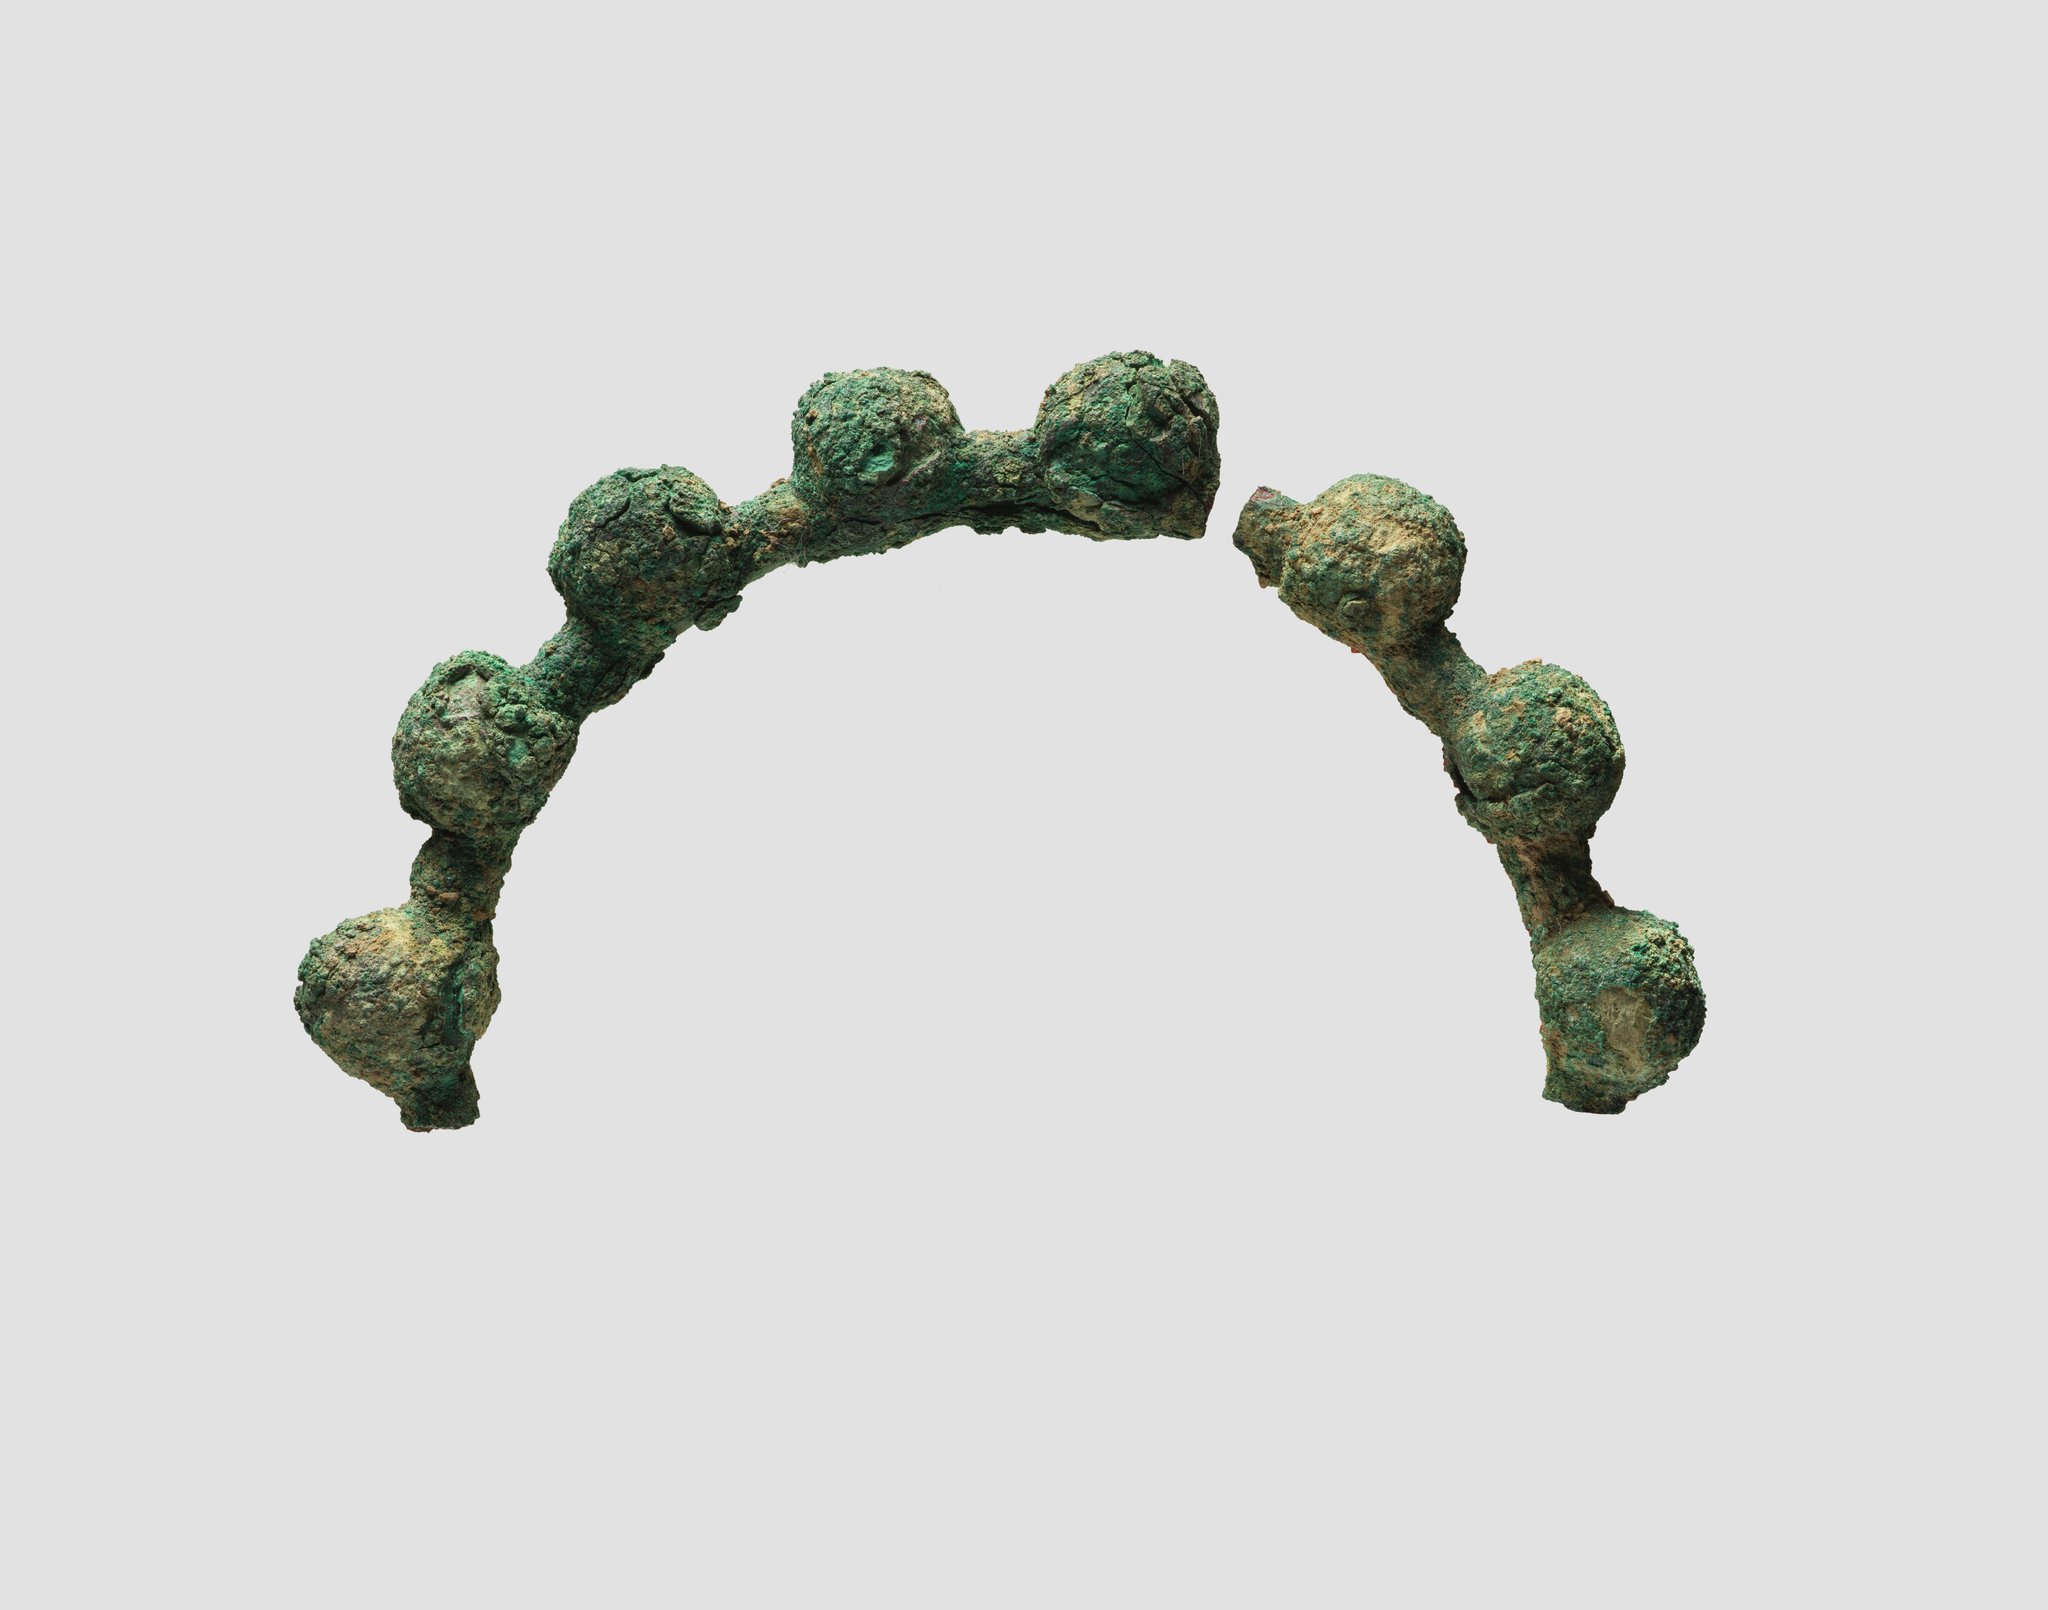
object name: bracelet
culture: iranian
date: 900-801 BCE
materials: bronze, copper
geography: iran